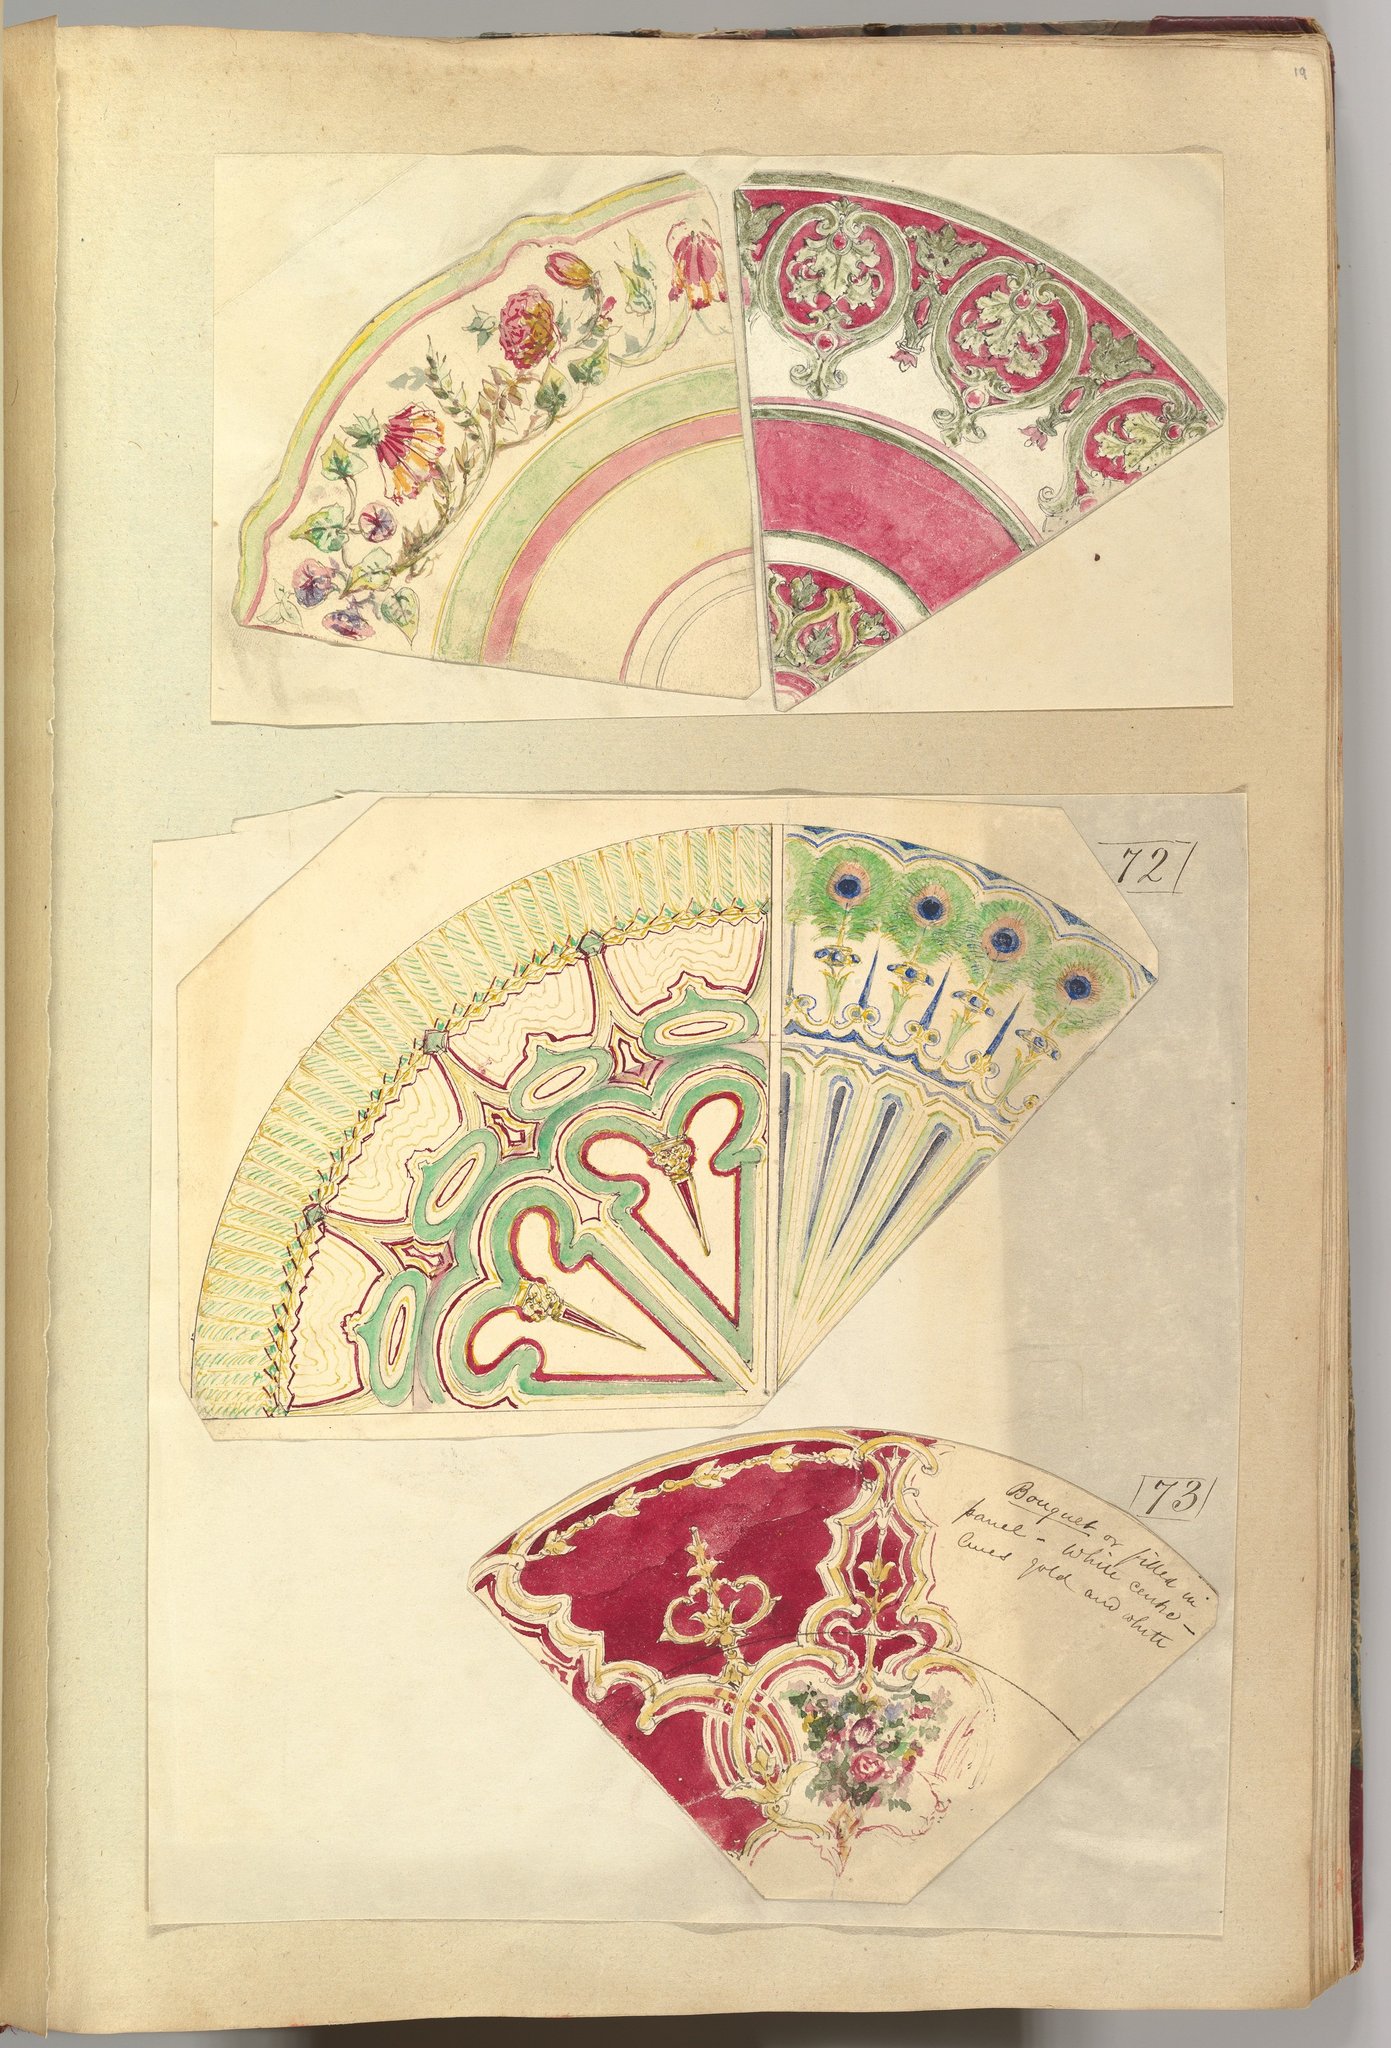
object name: drawing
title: Five Designs for Decorated Plates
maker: alfred henry forrester [alfred crowquill]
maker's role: artist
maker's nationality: british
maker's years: 1804-1872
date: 1845-1855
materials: ink, watercolor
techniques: pen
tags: flowers,leaves